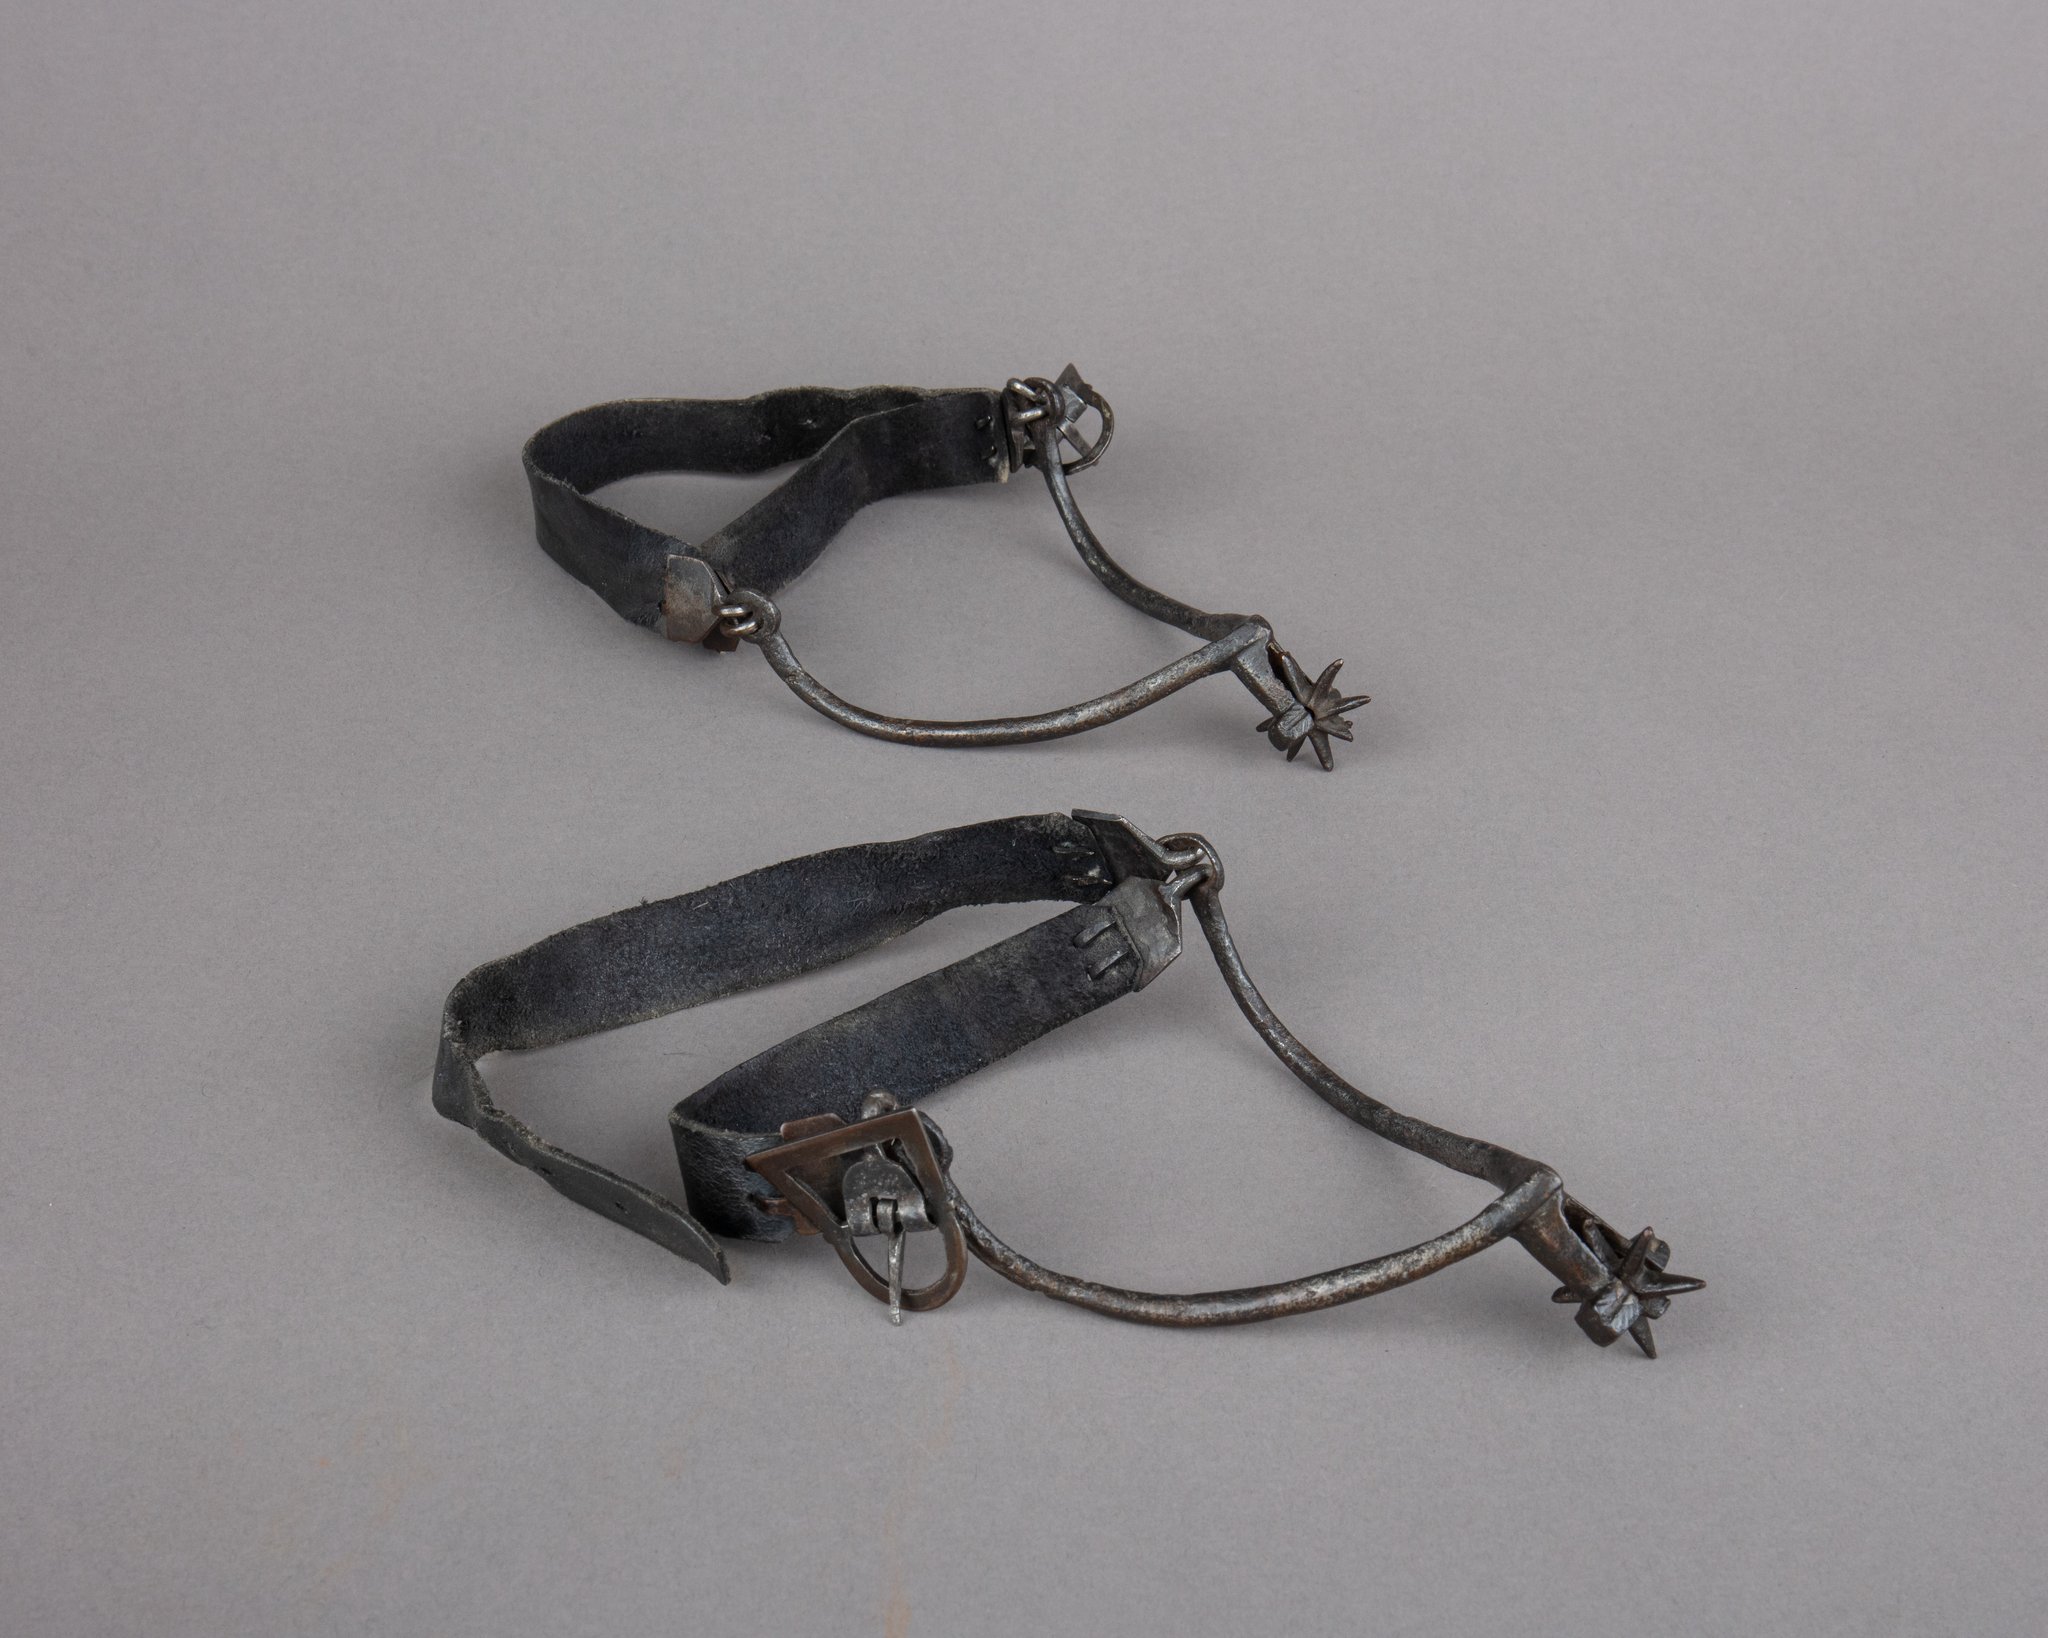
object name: spur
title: Pair of Rowel Spurs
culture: french or german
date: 1301-1350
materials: metal alloy, leather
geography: france